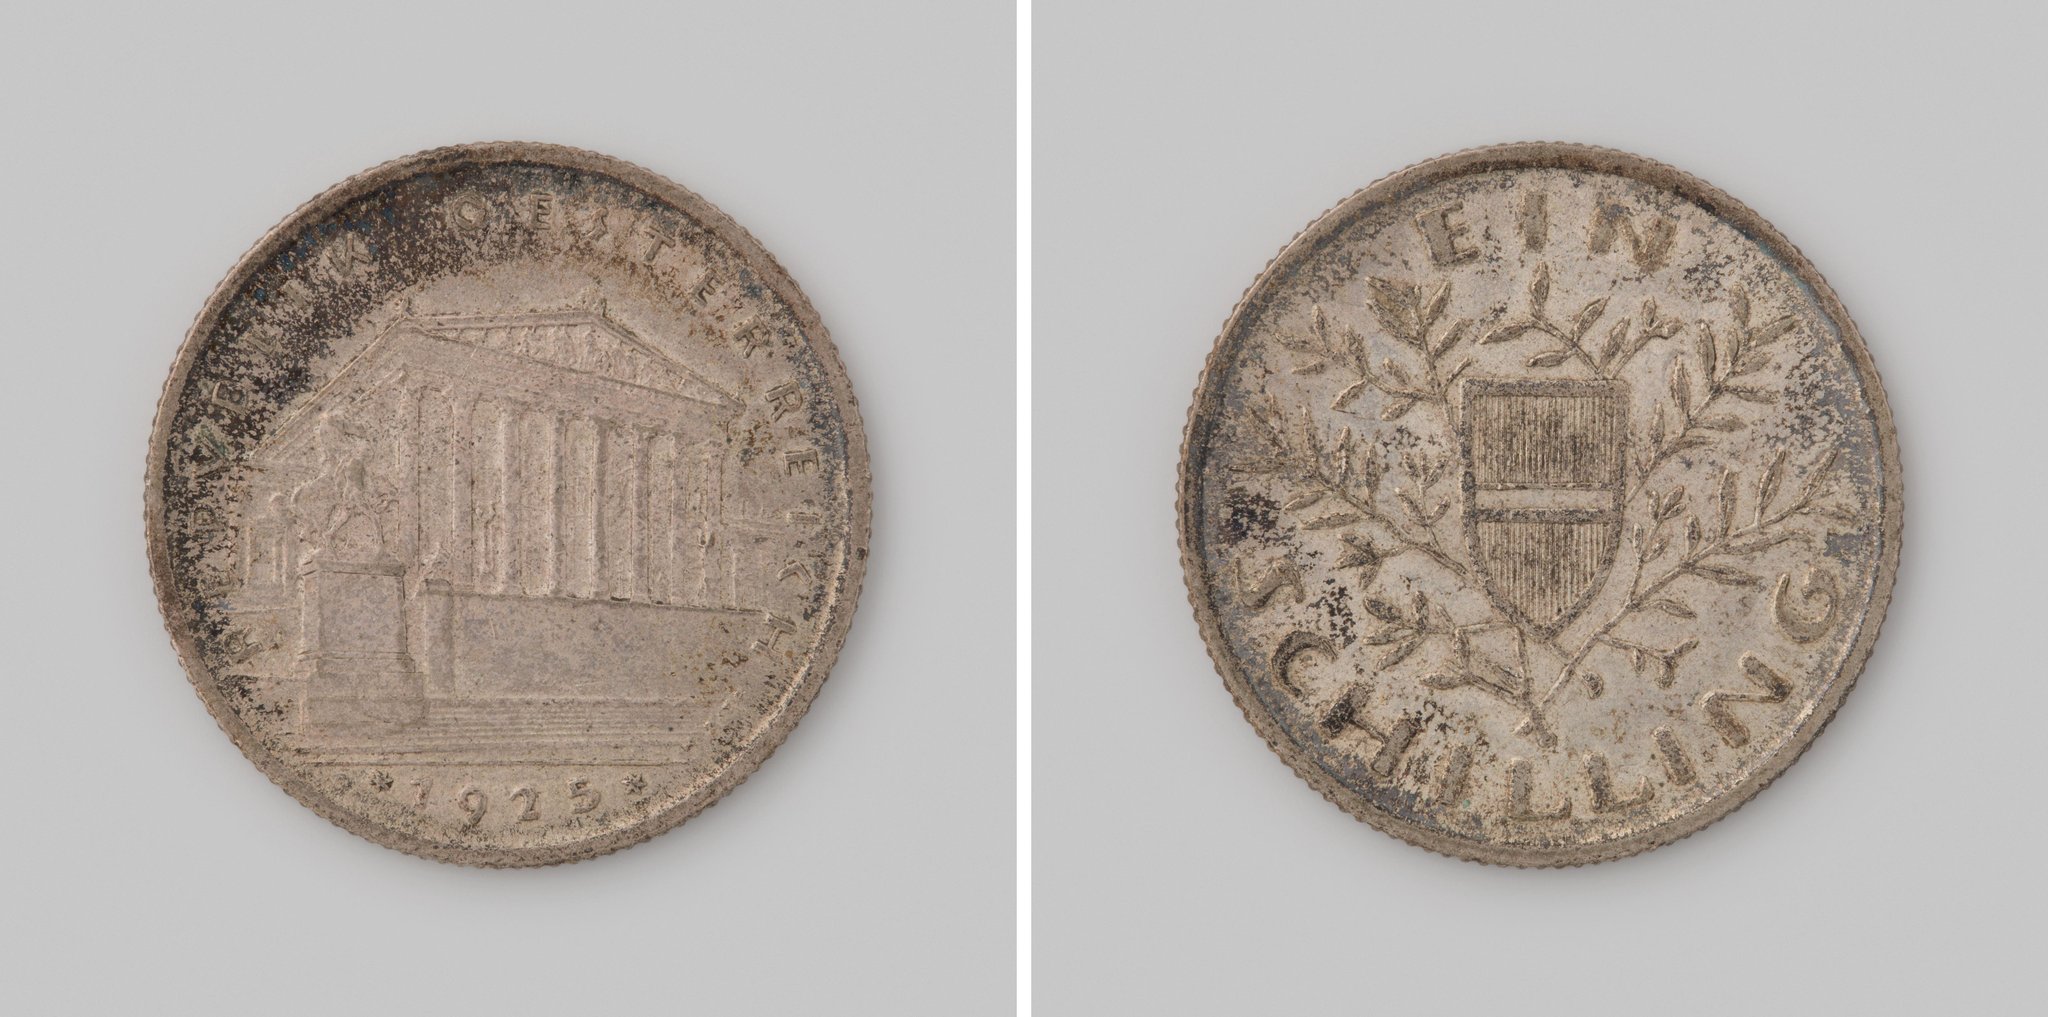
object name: coin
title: Republiek Oostenrijk, schilling,1925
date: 1925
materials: silver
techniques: striking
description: Zilveren munt. Voorzijde: parlementsgebouw met links voor twee standbeelden. Jaartal onderaan. Keerzijde: op takken wapenschild van Oostenrijk. Waarde-aanduiding als omschrift. Kartelrand.